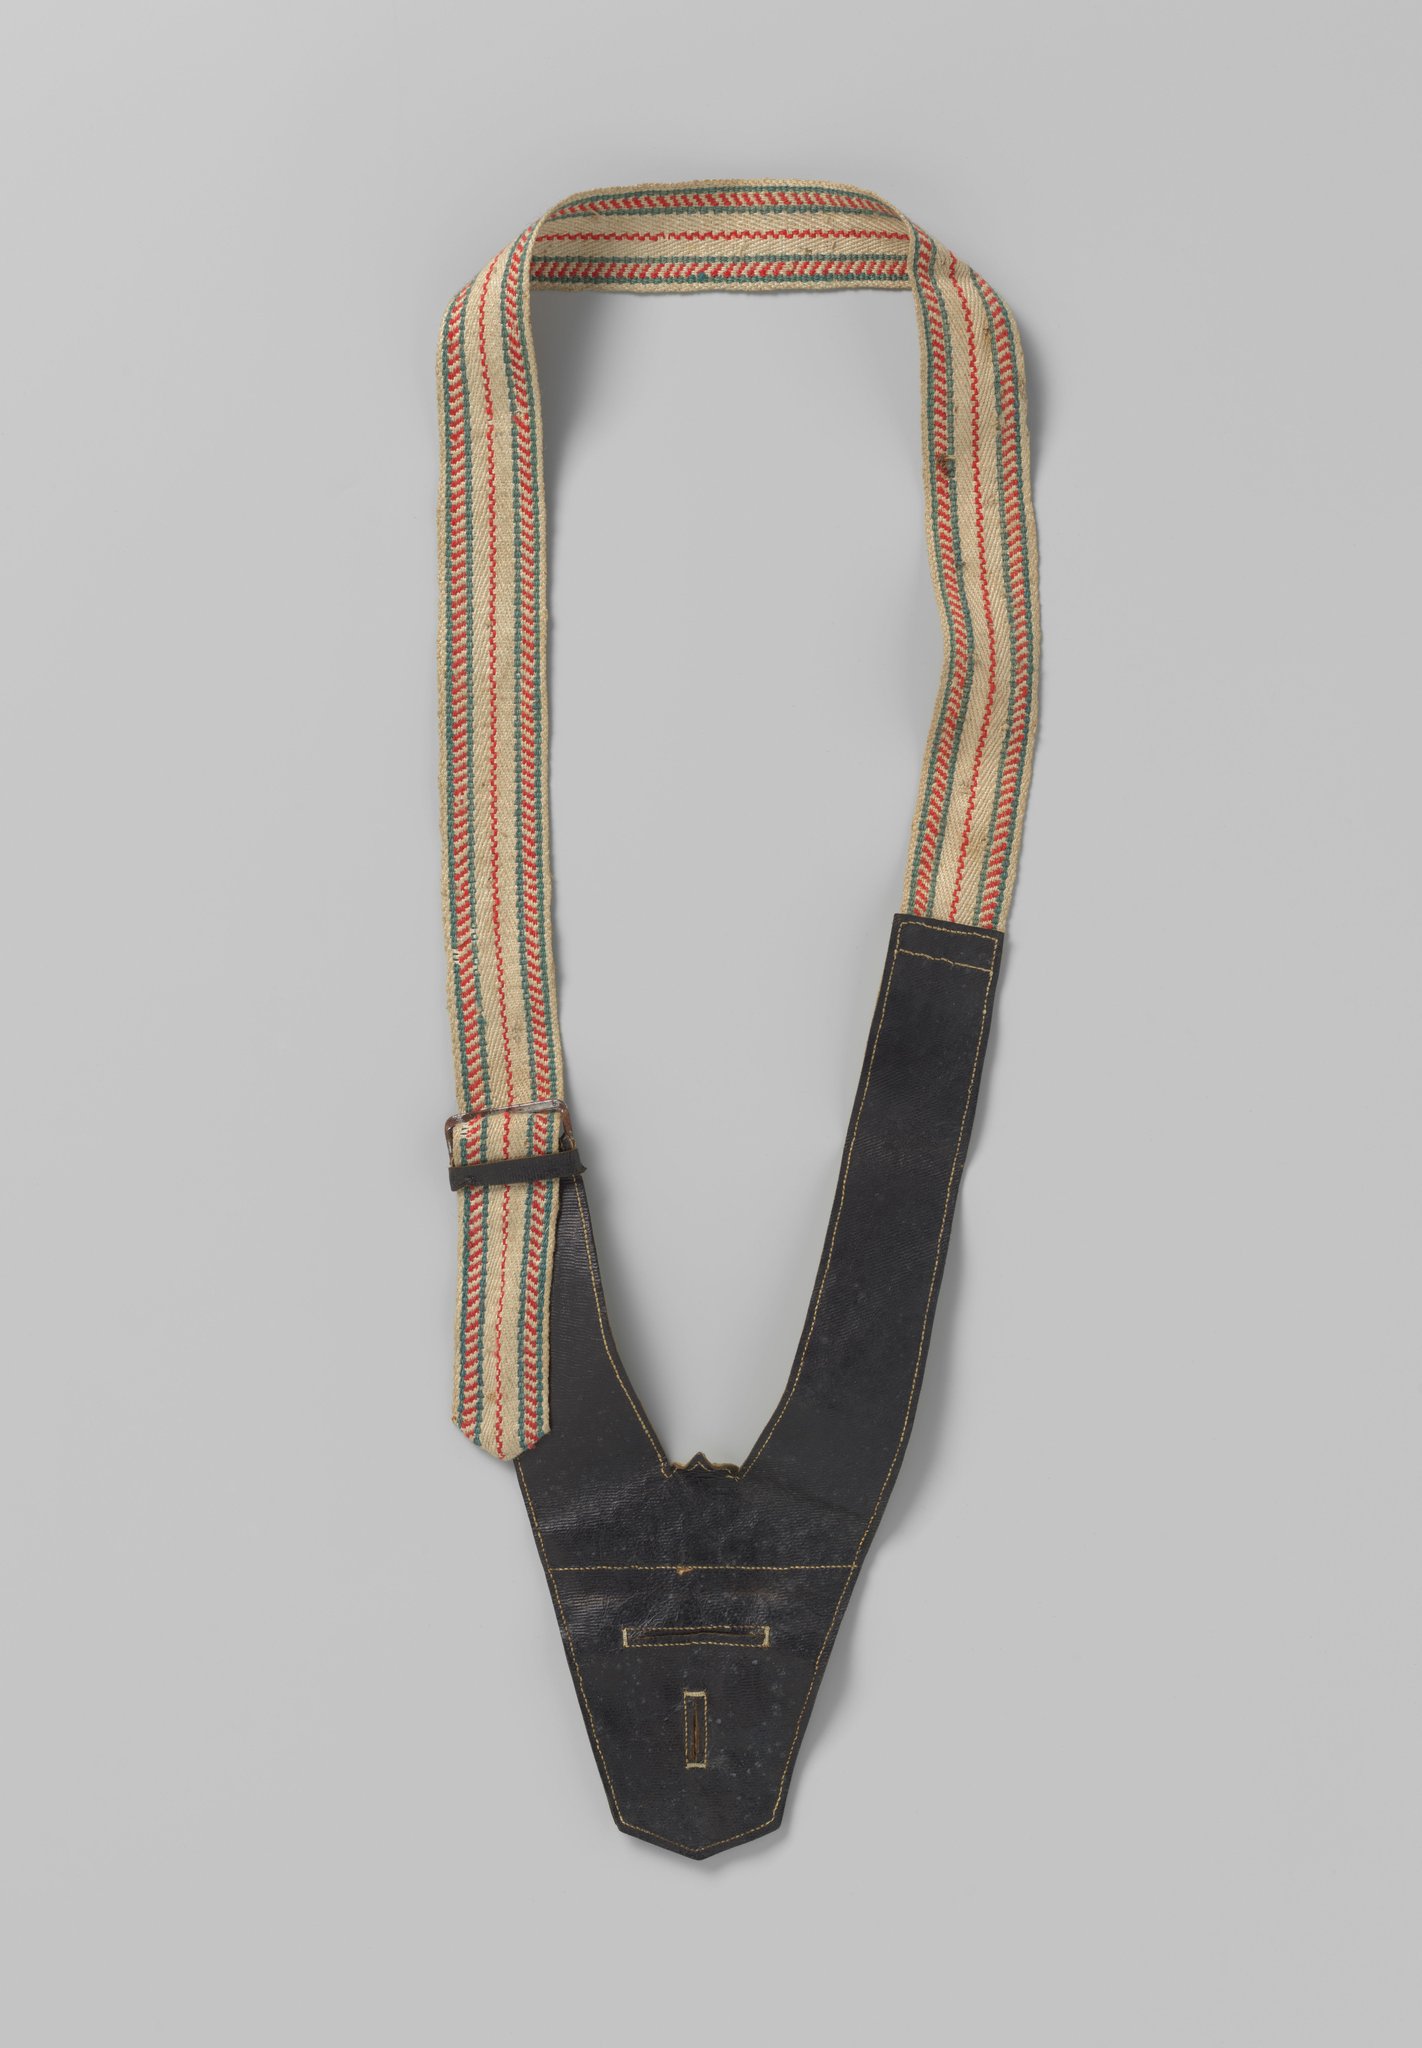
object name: koppel, koppelriem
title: Koppel of draagband van een V-vormig model met één langere poot van zwart leer, gevoerd met wit glacé; riem van wit singelband met groene en rode strepen, onderdeel van een schutterij-uniform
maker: Anonymous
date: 1834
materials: leather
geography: amsterdam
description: Koppel of draagband van een V-vormig model met één langere poot van zwart leer, gevoerd met wit glacé; riem van wit singelband met groene en rode strepen, onderdeel van een schutterij-uniform.